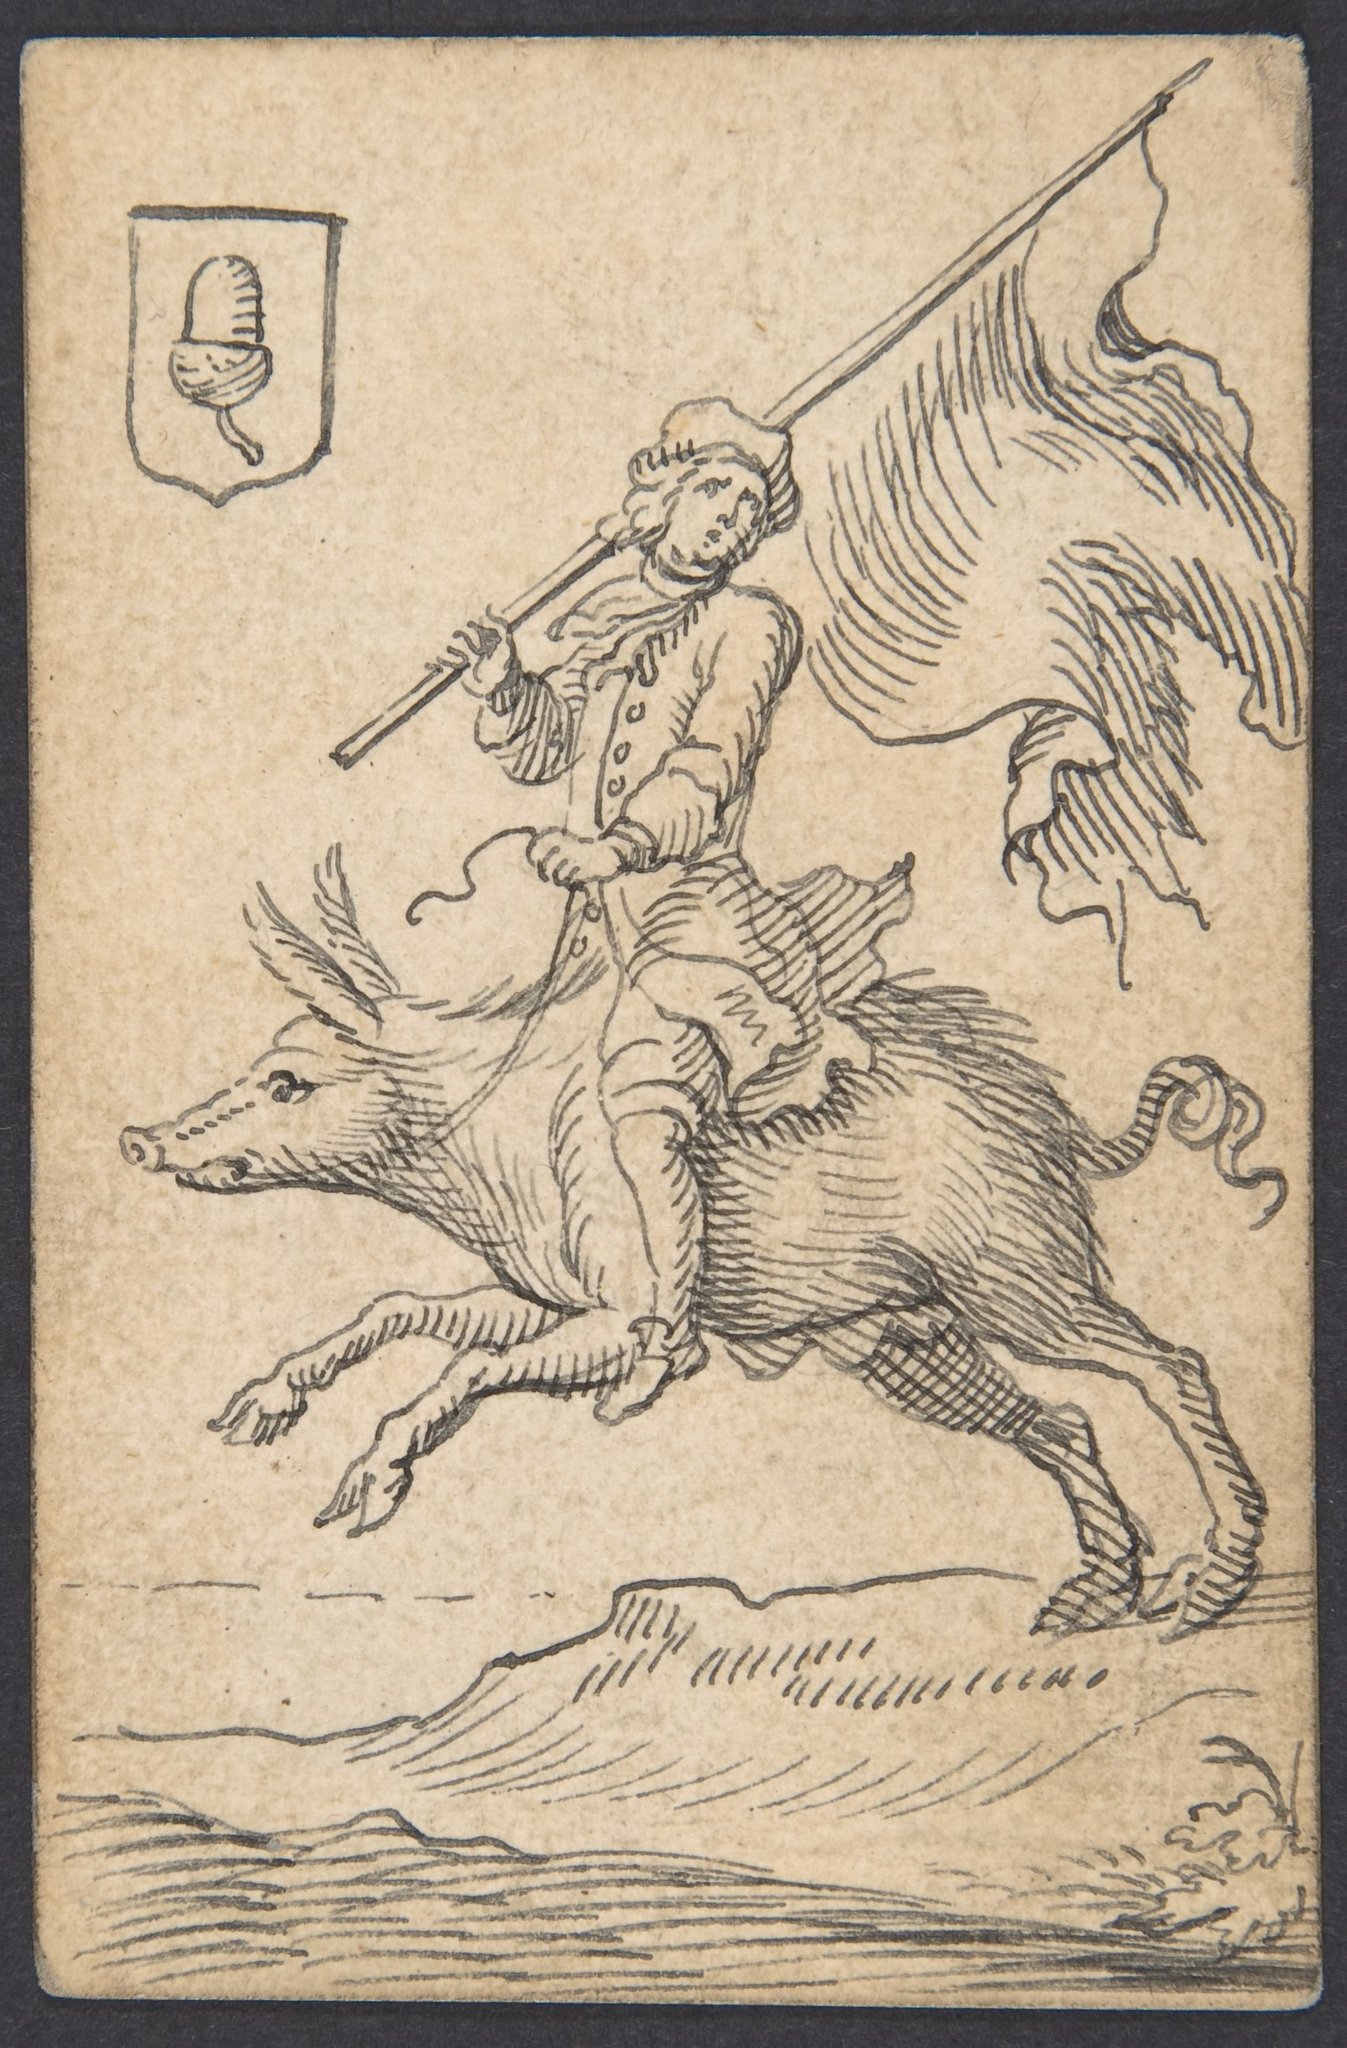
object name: drawing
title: Acorn Knave: A Man Astride a Swine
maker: johannes brandenberg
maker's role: artist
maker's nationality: swiss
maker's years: 1661-1729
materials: ink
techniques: pen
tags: men,pigs,flags